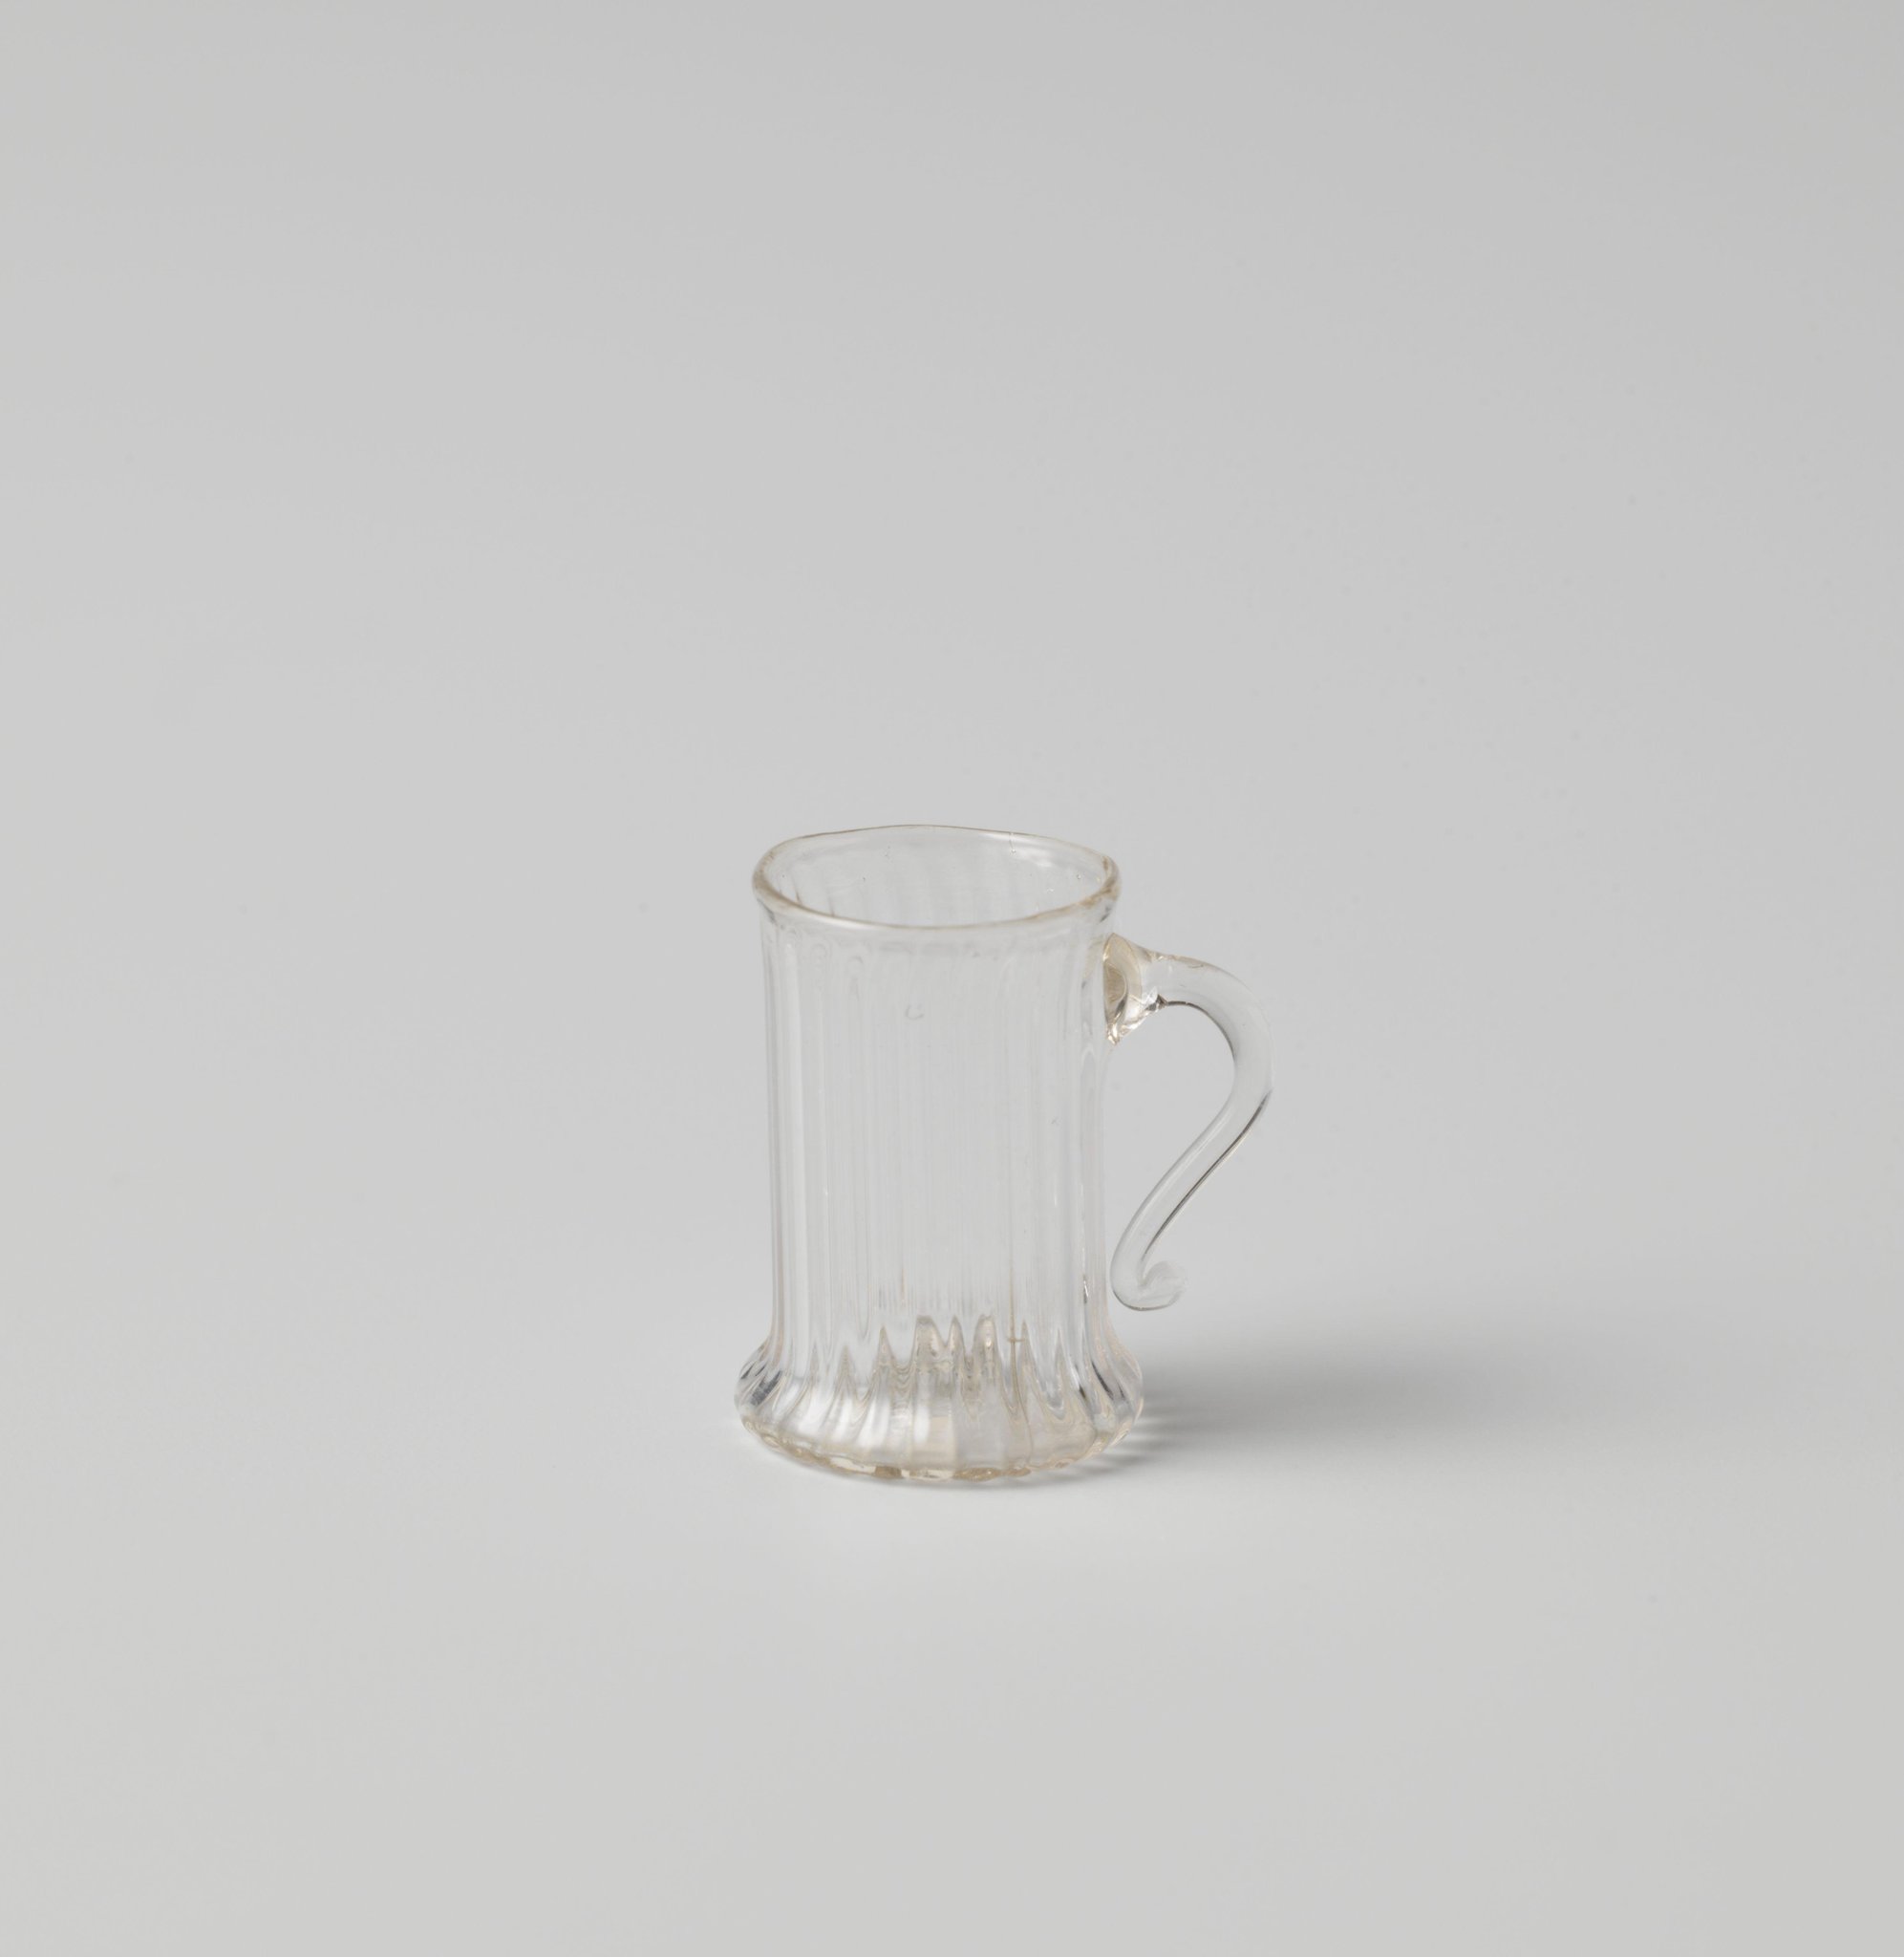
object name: miniature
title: Beker met oor, het lichaam cilindrisch met verticale ribbels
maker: Anonymous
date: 1675-1699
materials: glass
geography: haarlem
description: Beker van helder kleurloos glas, cilindrische van vorm, verticaal geribd, met verbrede naar binnen gestoken bodem, en aangezet oor eindigend in krul.